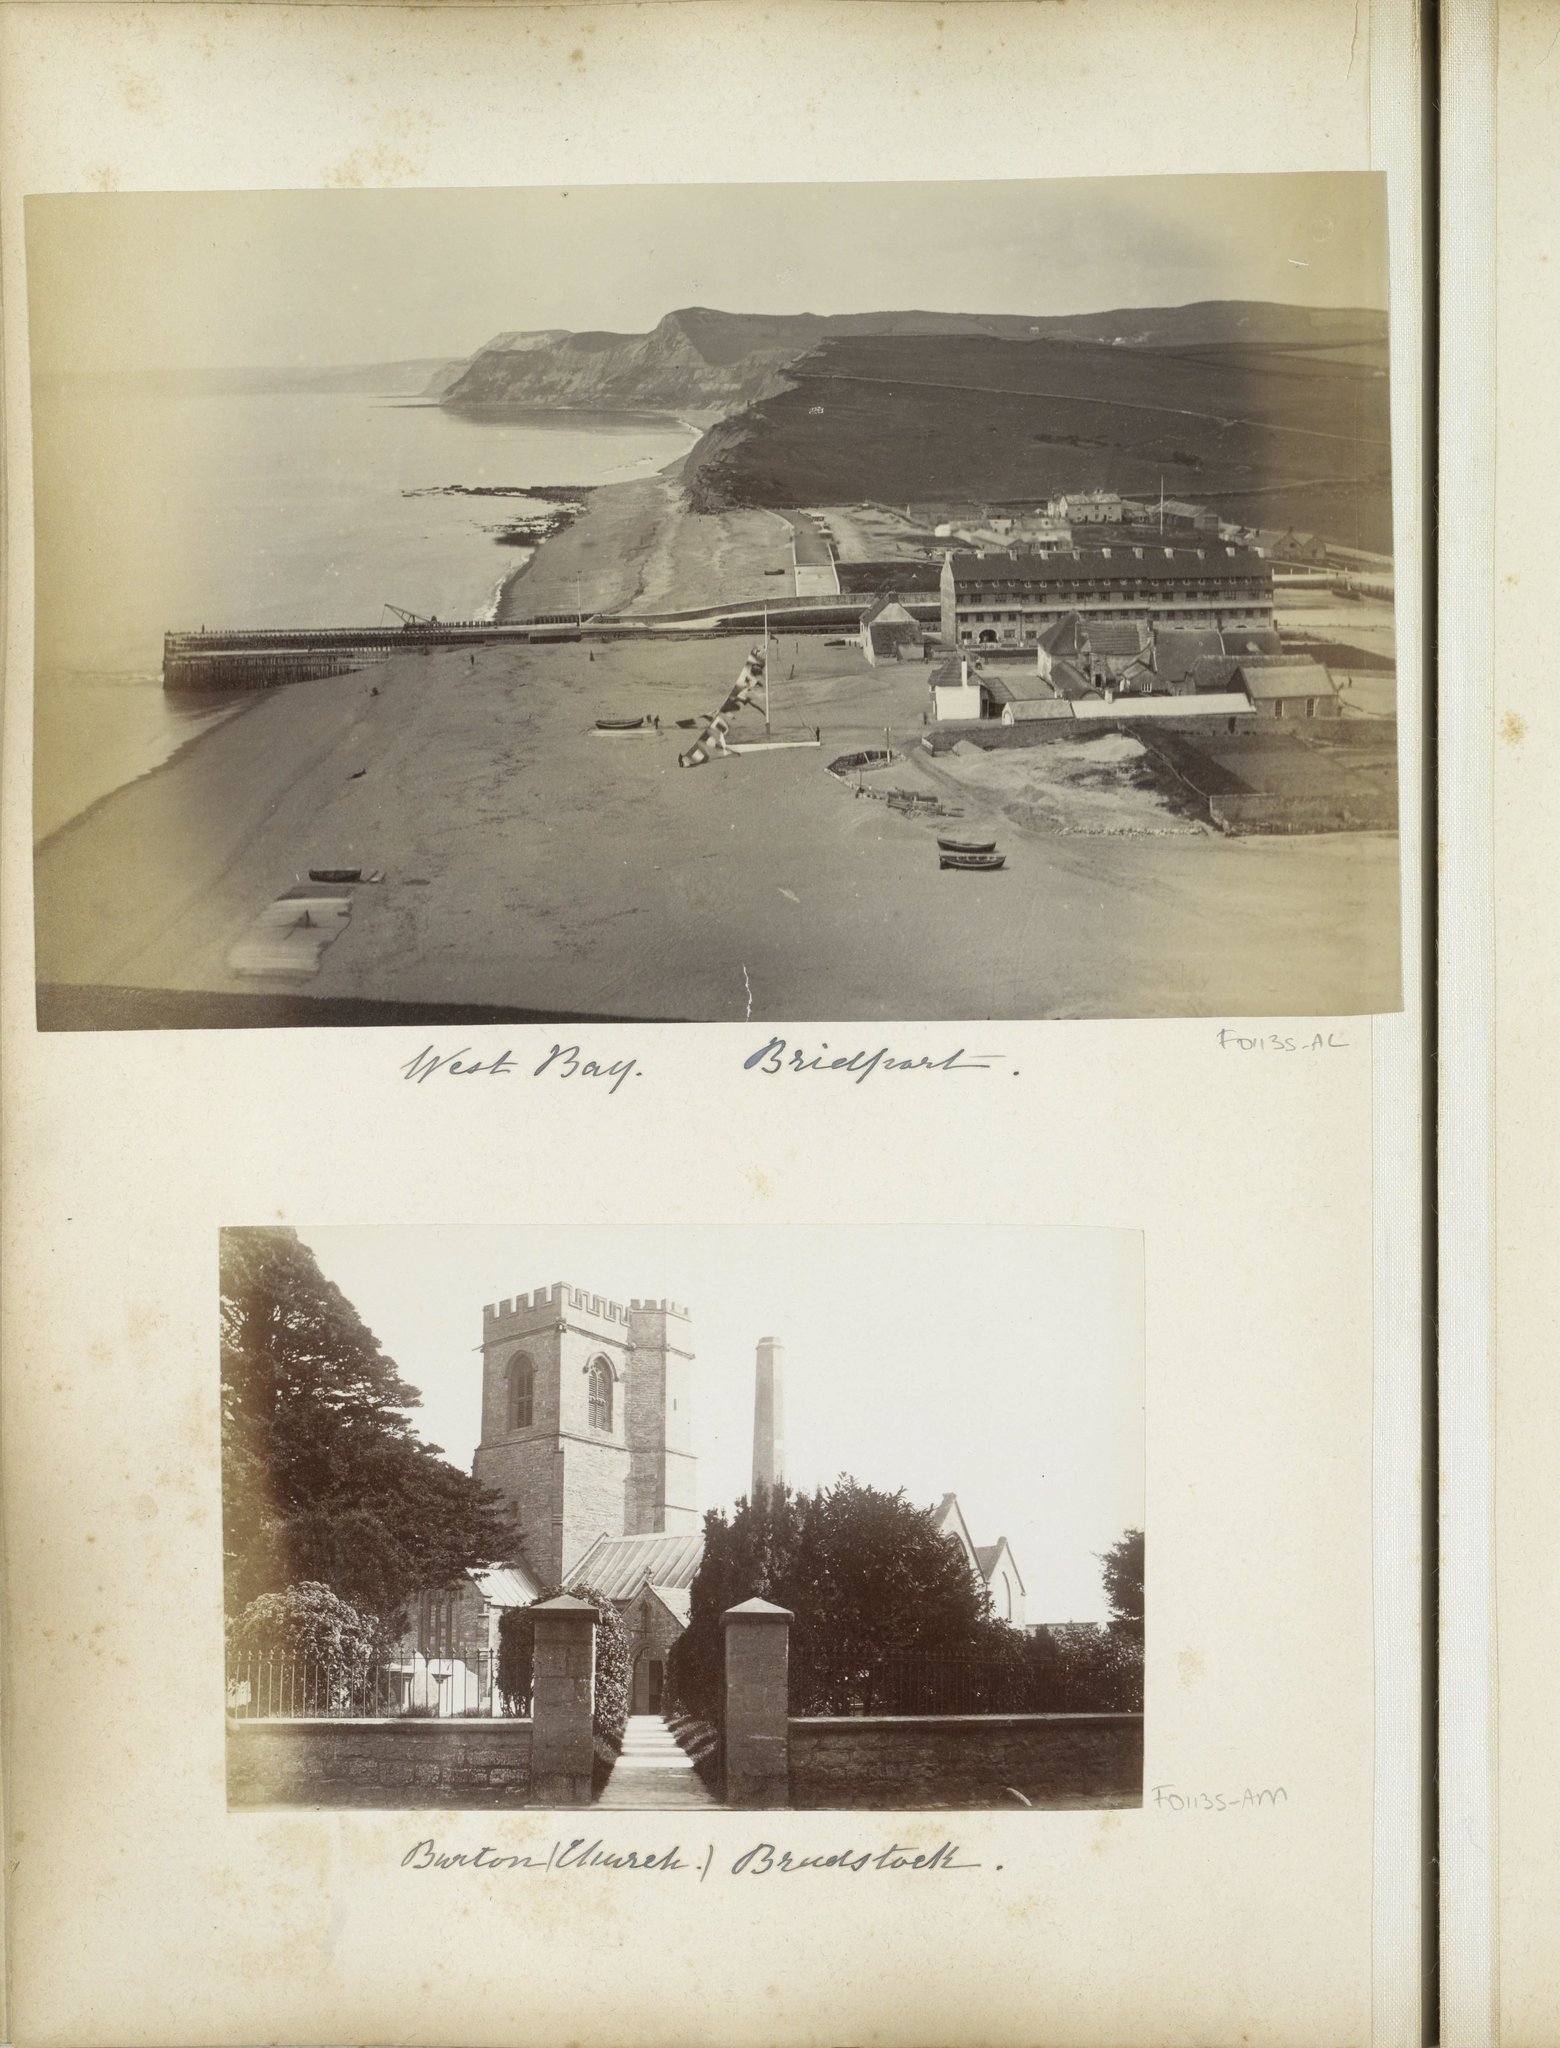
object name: album leaf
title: Gezicht op West Bay in Bridport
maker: Anonymous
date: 1898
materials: paper, photographic support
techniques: albumen print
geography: bridport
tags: pier, quay, wharf, coast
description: Onderdeel van Reisalbum met foto's van bezienswaardigheden in Engeland en Frankrijk.